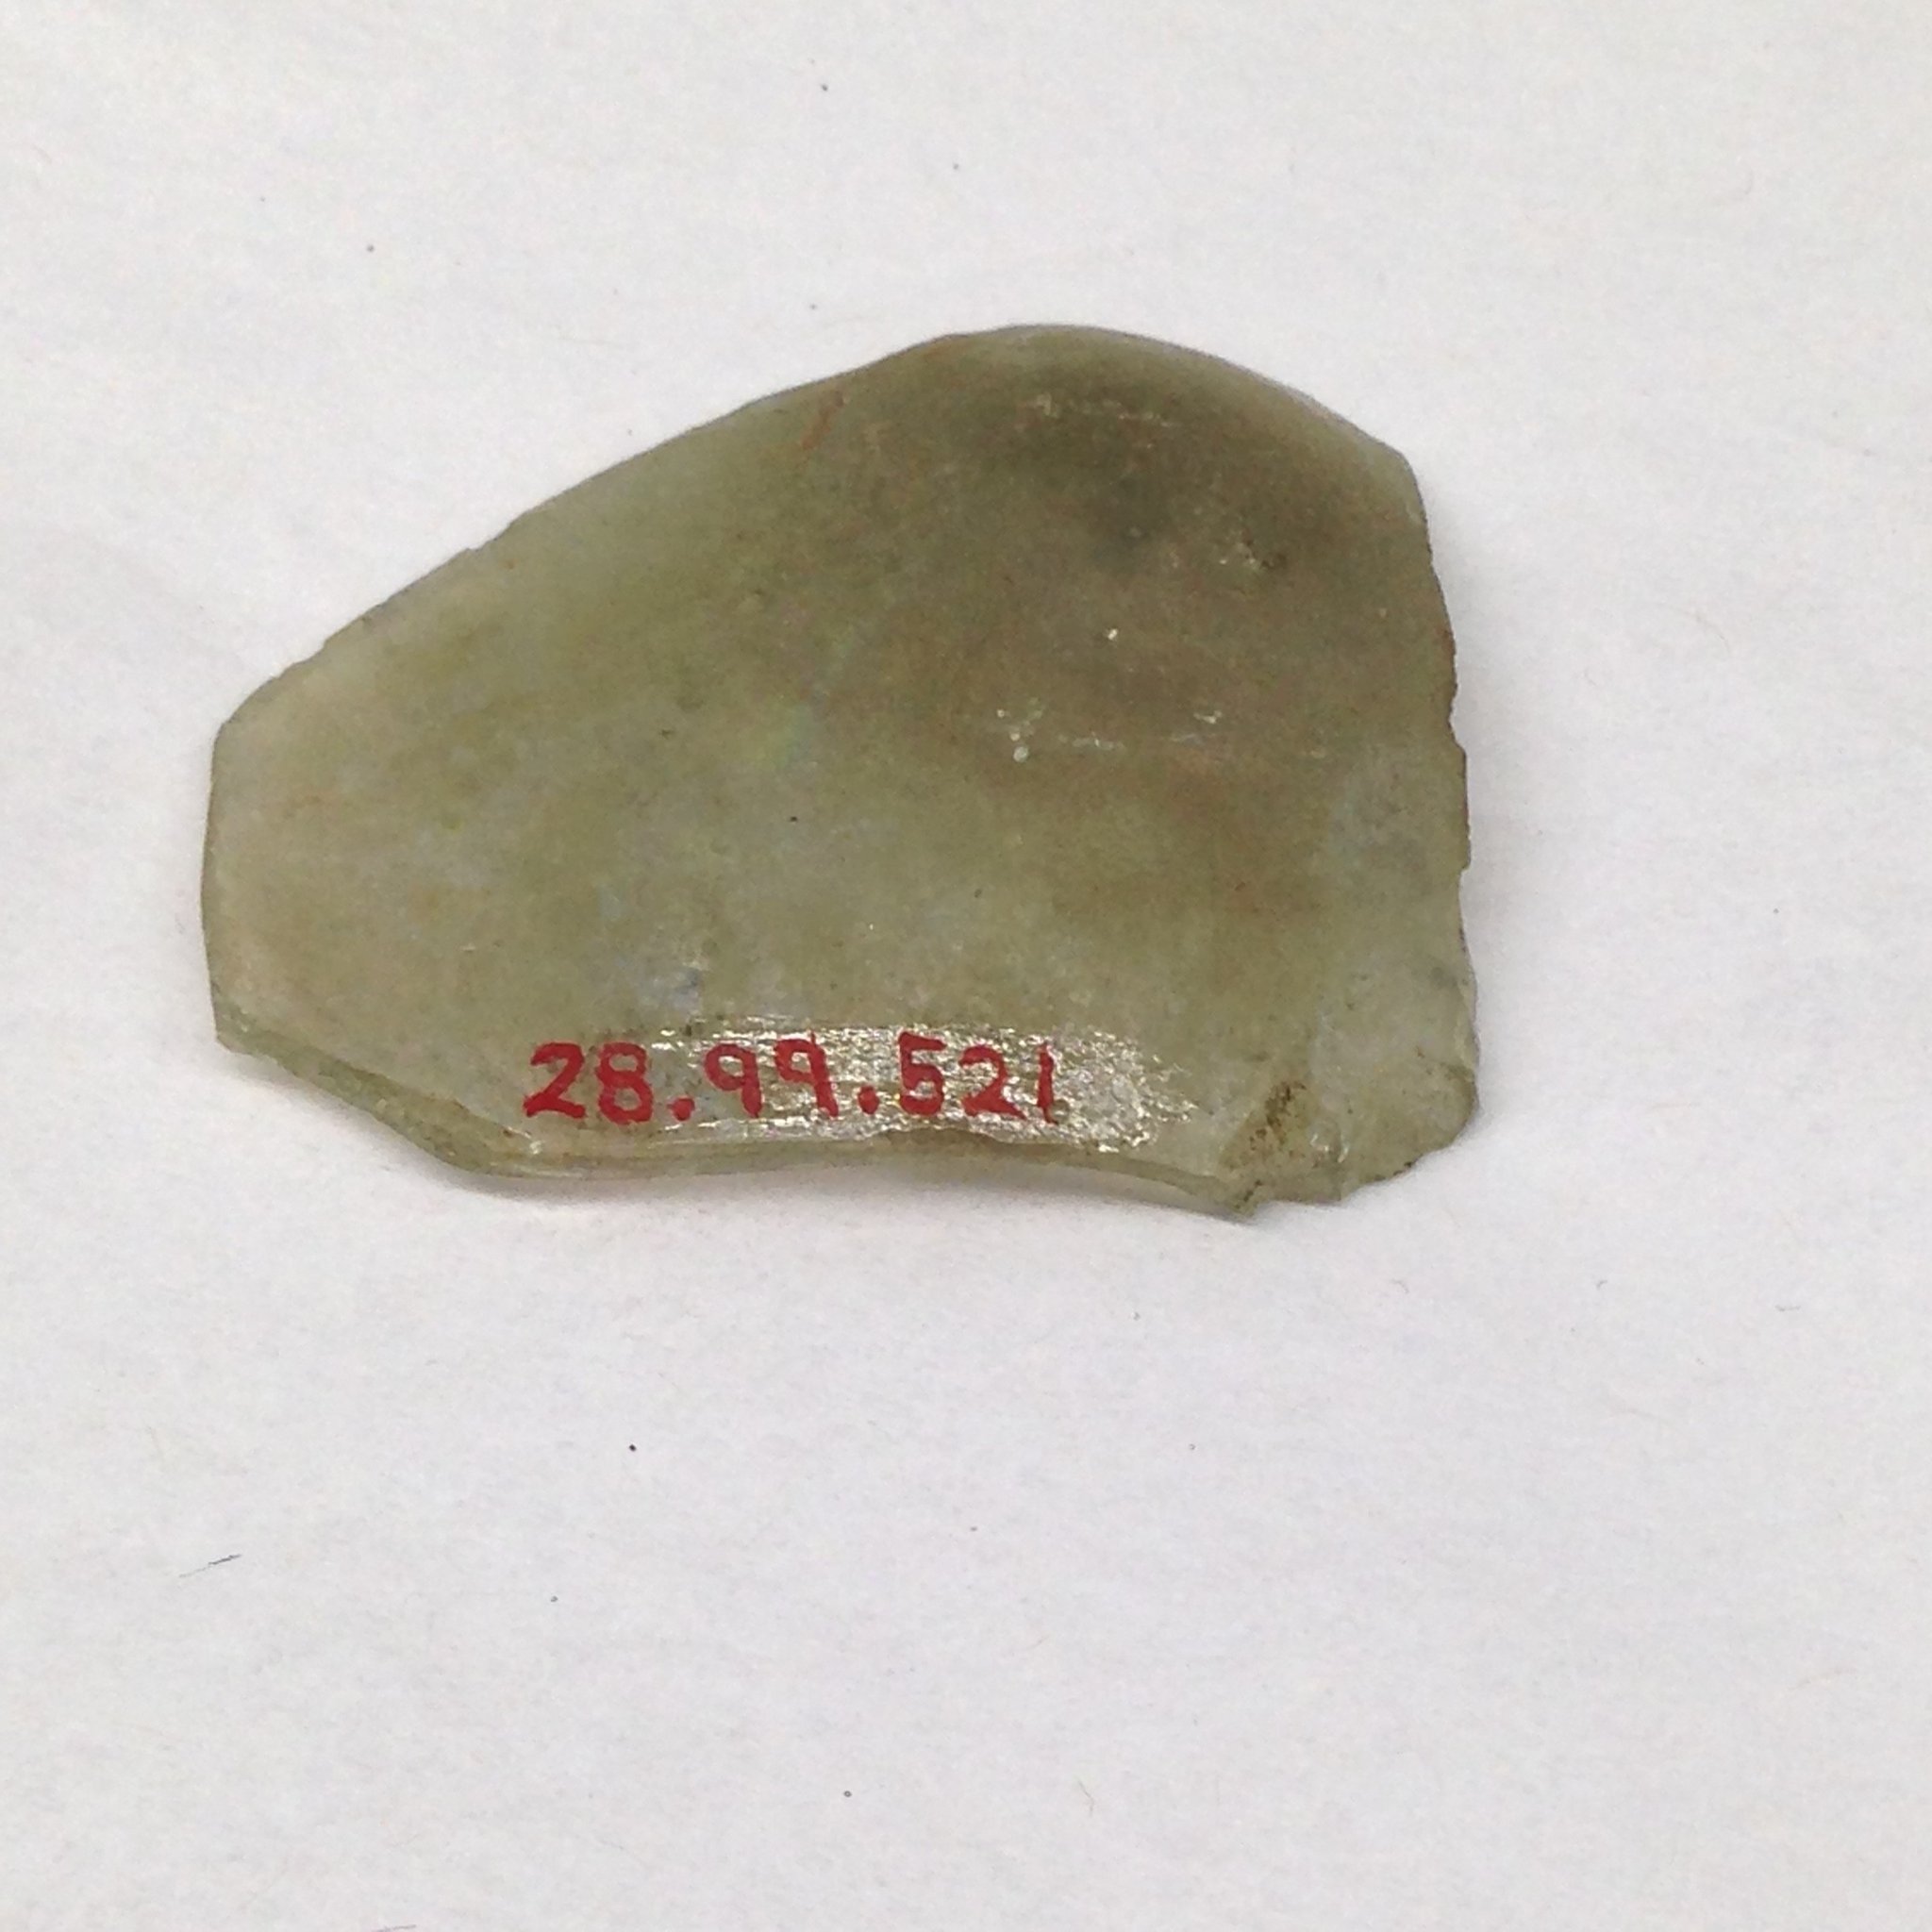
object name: fragment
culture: european or middle eastern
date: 1150-1250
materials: ceramic, glass